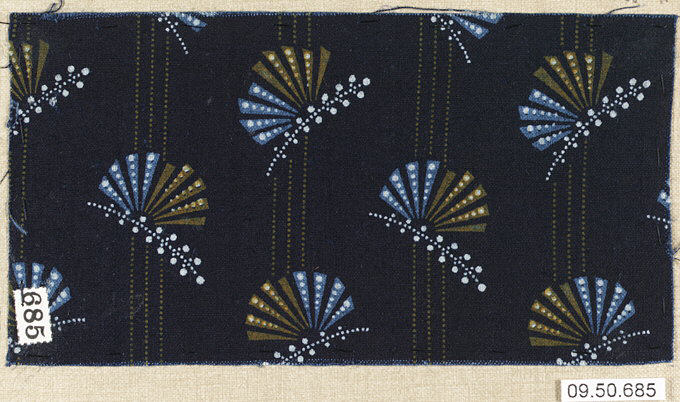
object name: piece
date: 1801-1900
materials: cotton